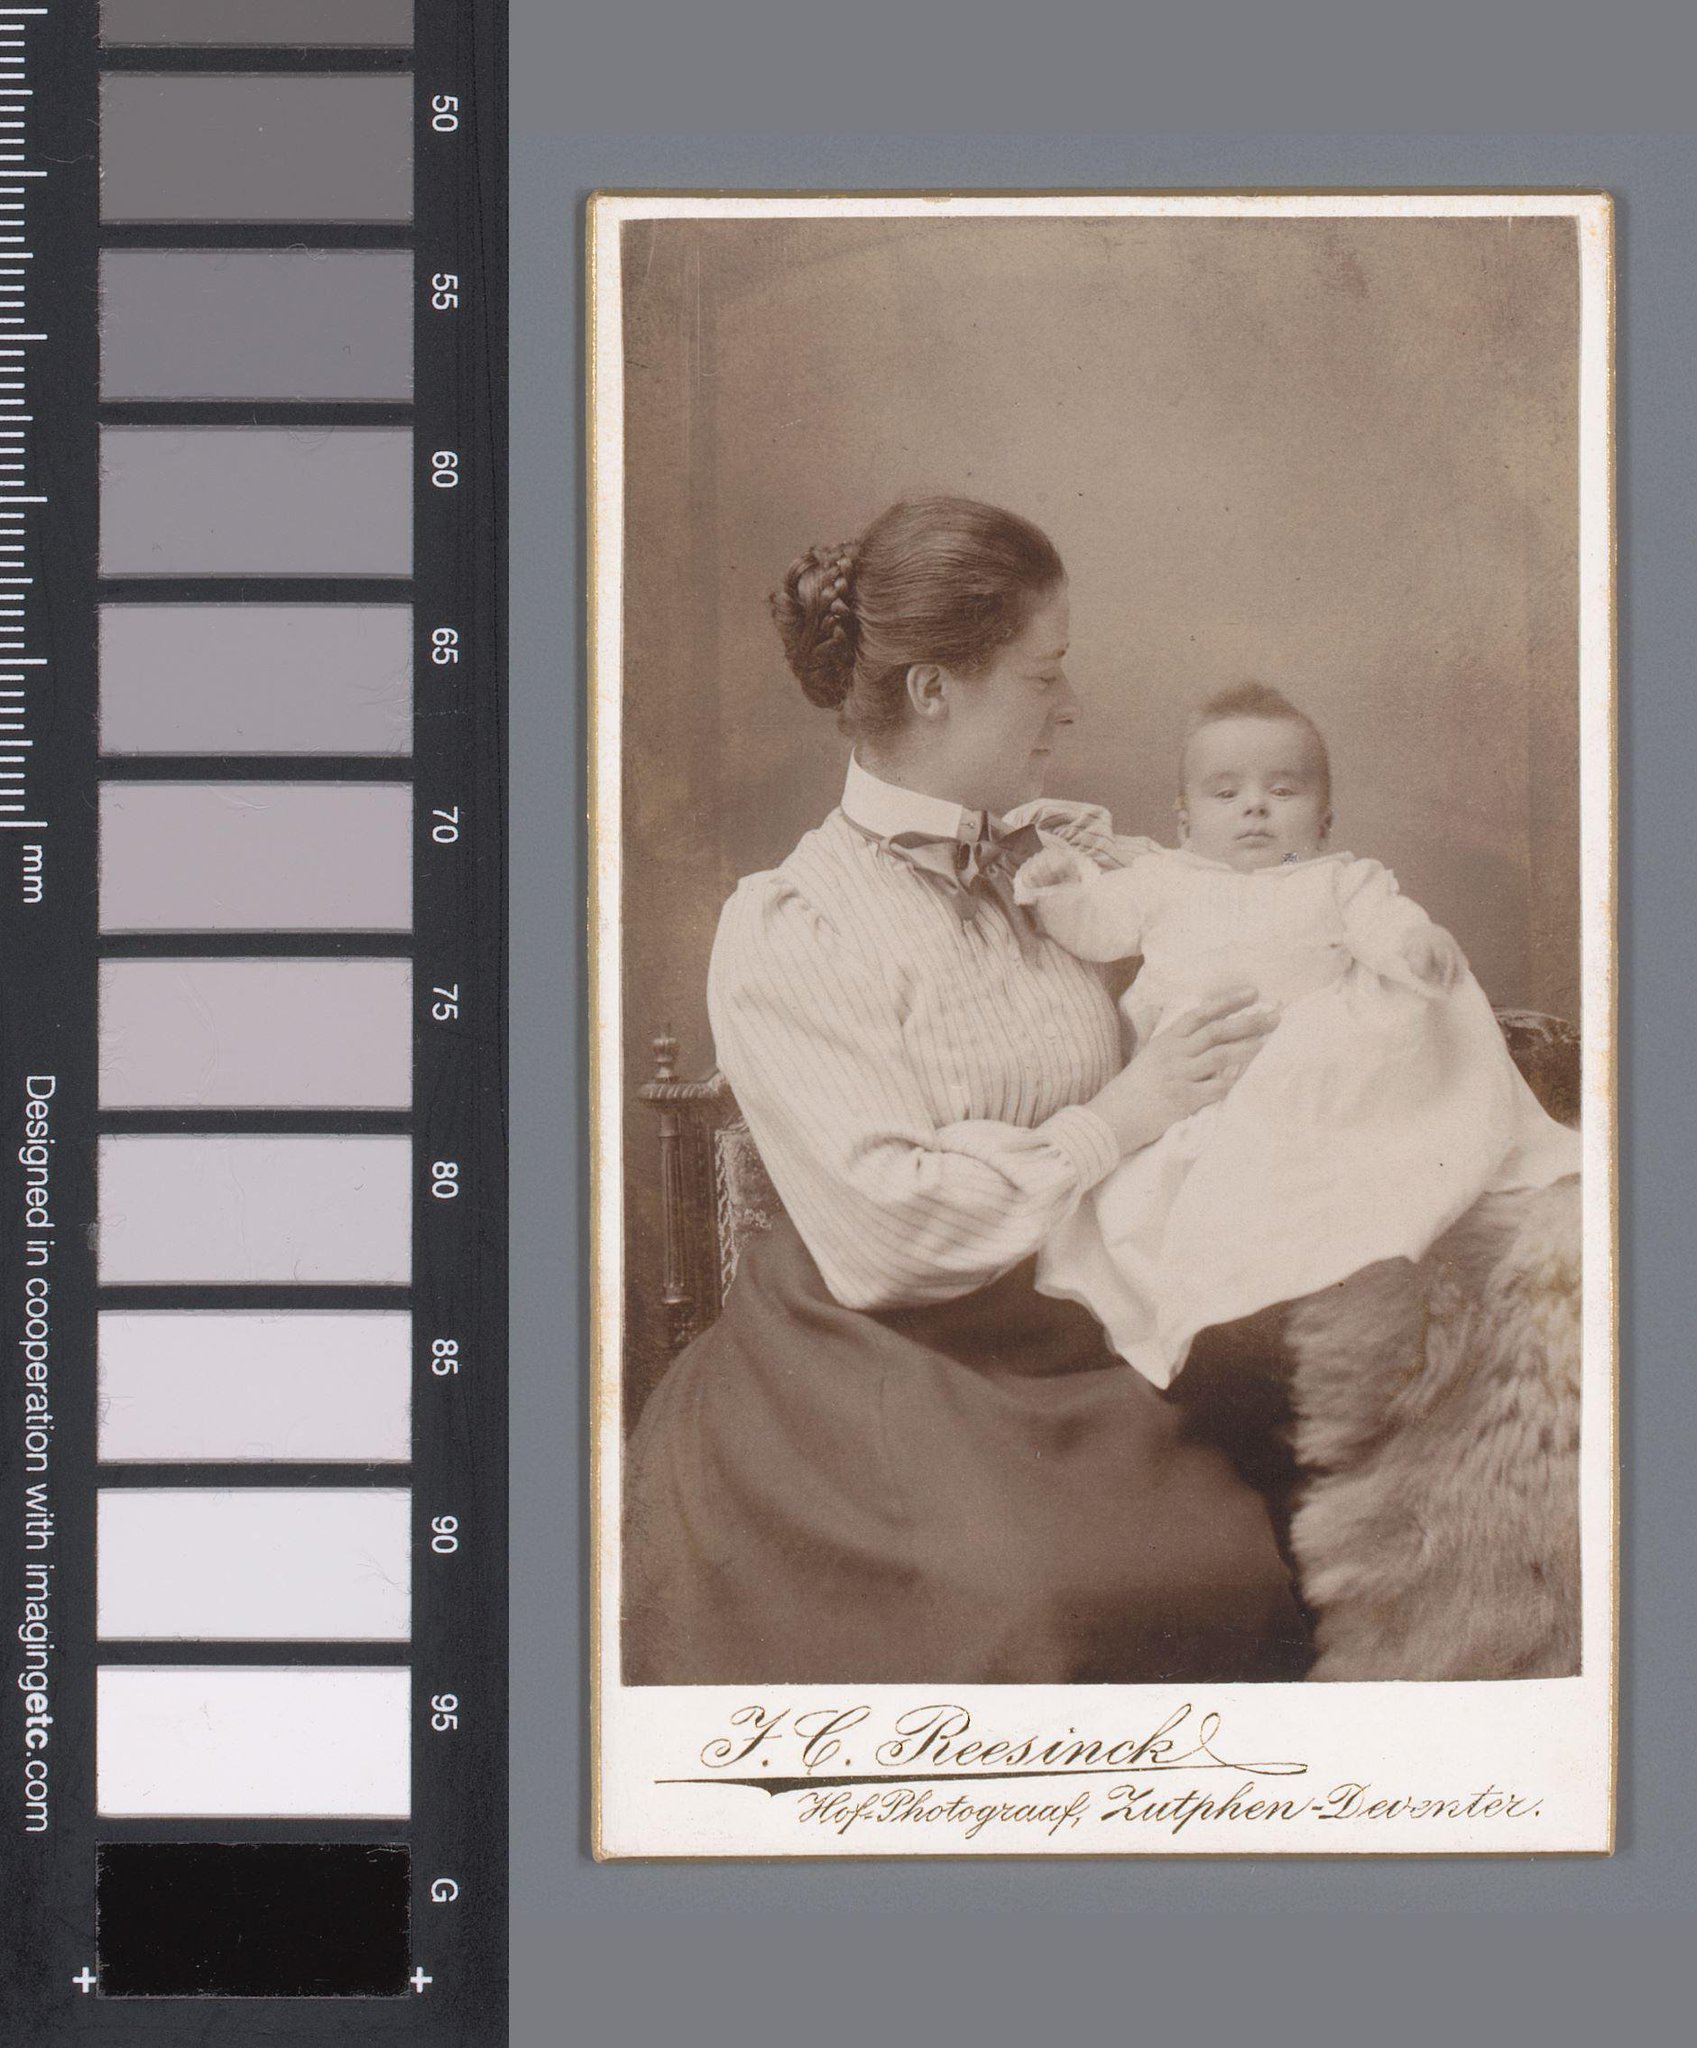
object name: carte de visite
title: Portret van Charlotte Hooykaas van der Linden met haar zoon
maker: johan christiaan reesinck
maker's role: fotograaf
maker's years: 1838-1922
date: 1891-1922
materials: cardboard, photographic support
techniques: collodion silver print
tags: historical persons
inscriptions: workshop stamp: ‘Reesinck, J.C./ Zutphen Deventer’, annotation: ‘Charlotte Hoogkaas v.d. Linden met zoon Piet’